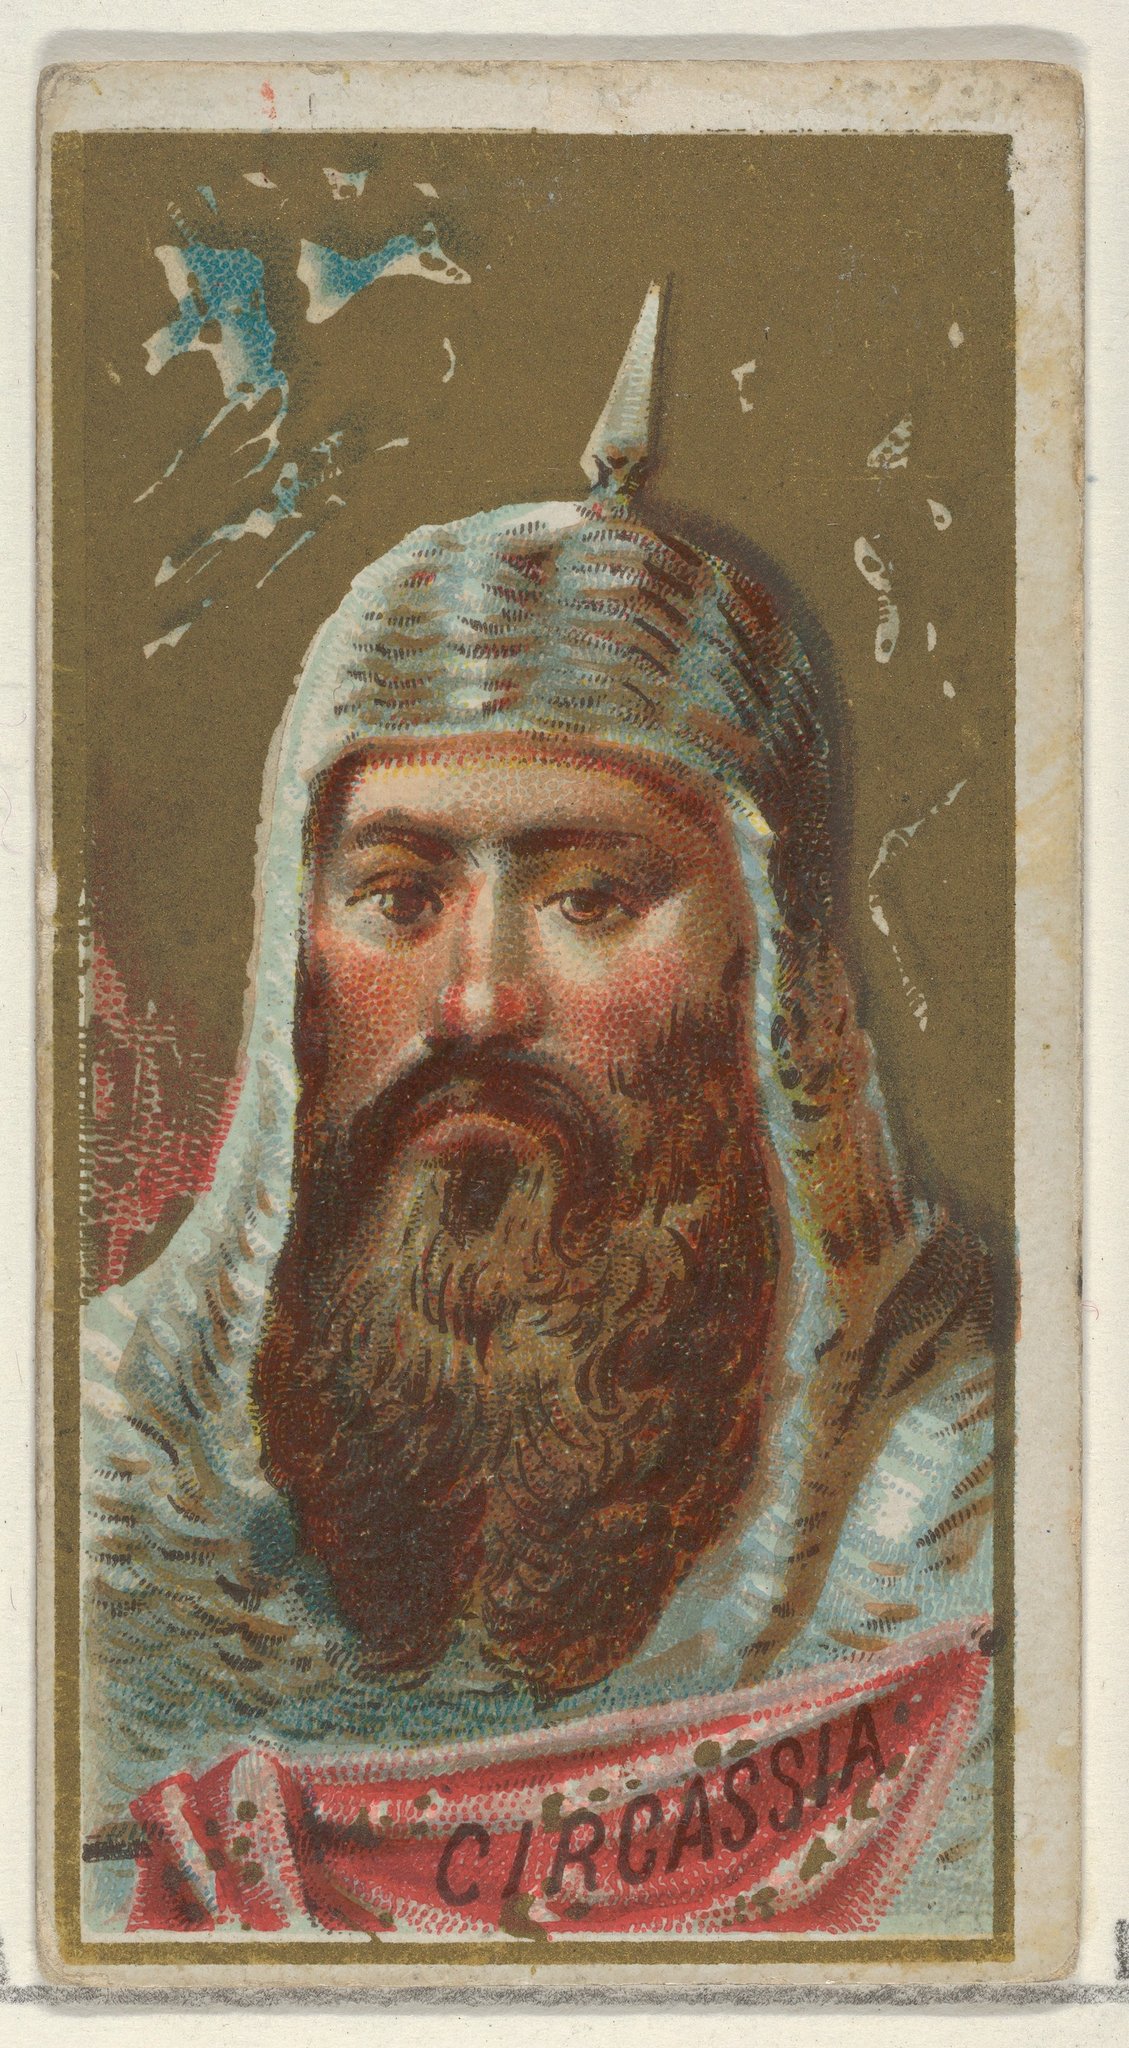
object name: print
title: Circassia, from the Types of All Nations series (N24) for Allen & Ginter Cigarettes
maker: allen & ginter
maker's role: publisher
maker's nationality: american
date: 1889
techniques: color lithograph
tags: men